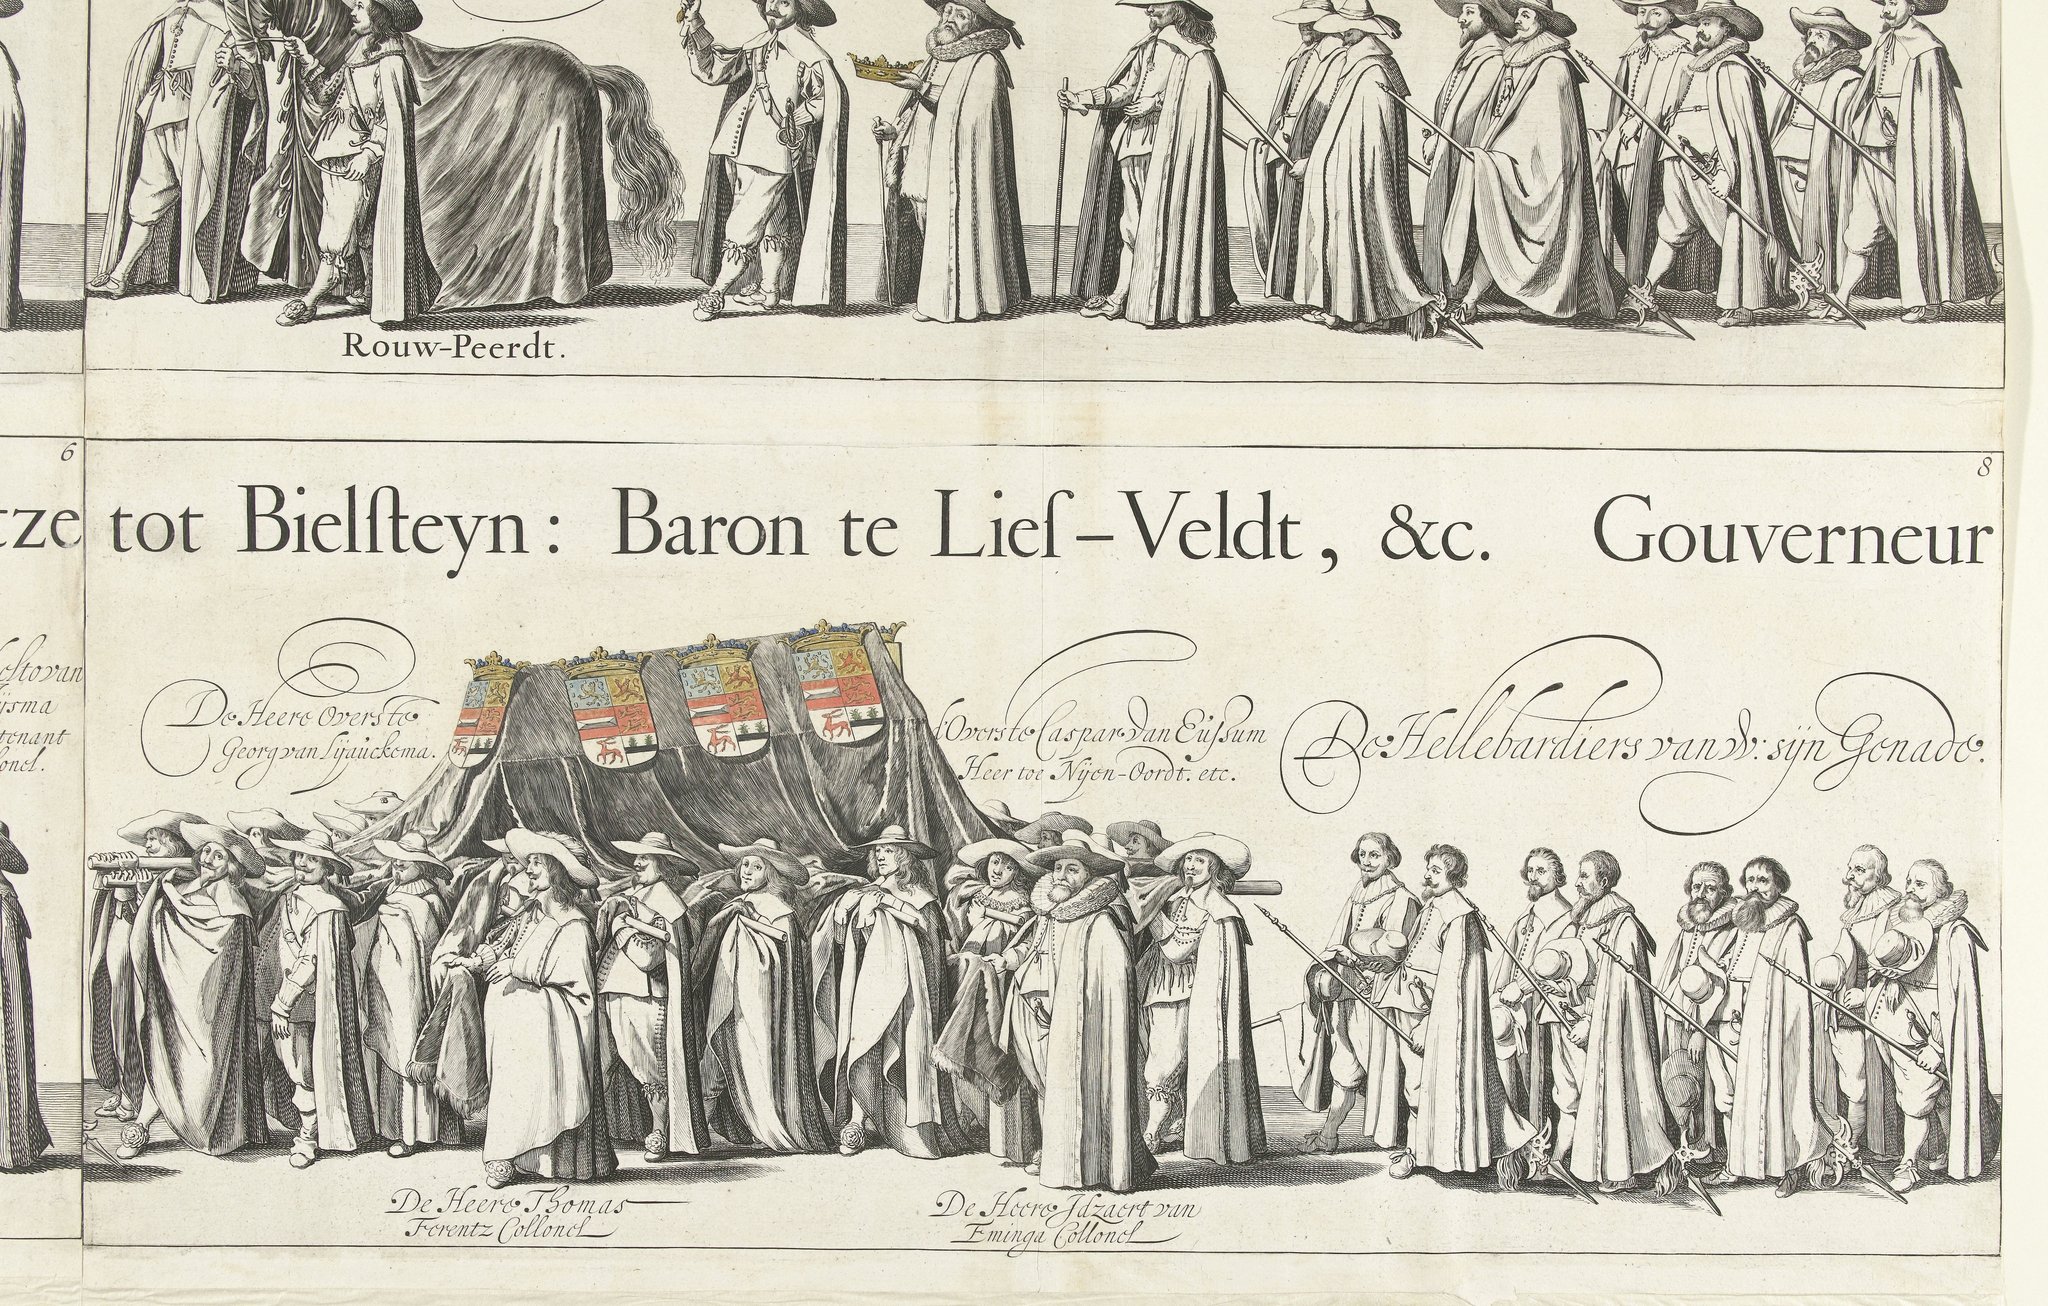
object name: print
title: Begrafenis van Ernst Casimir, graaf van Nassau-Dietz te Leeuwarden, 1633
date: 1634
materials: paper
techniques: engraving, etching, hand coloring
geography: northern netherlands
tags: ernst casimir graaf van nassau-dietz, cortege, funeral procession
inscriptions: date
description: Deel van de begrafenisstoet met de lijkkist en hellebaardiers. Bovenin de namen van de afgebeelde personen. Plaat nr. 8 in de prentserie van de begrafenis van Ernst Casimir, graaf van Nassau-Dietz te Leeuwarden, 3 januari 1633. De wapens en vaandels zijn ingekleurd. Dit blad samen met bladen 5, 6 en 7 aan elkaar geplakt.